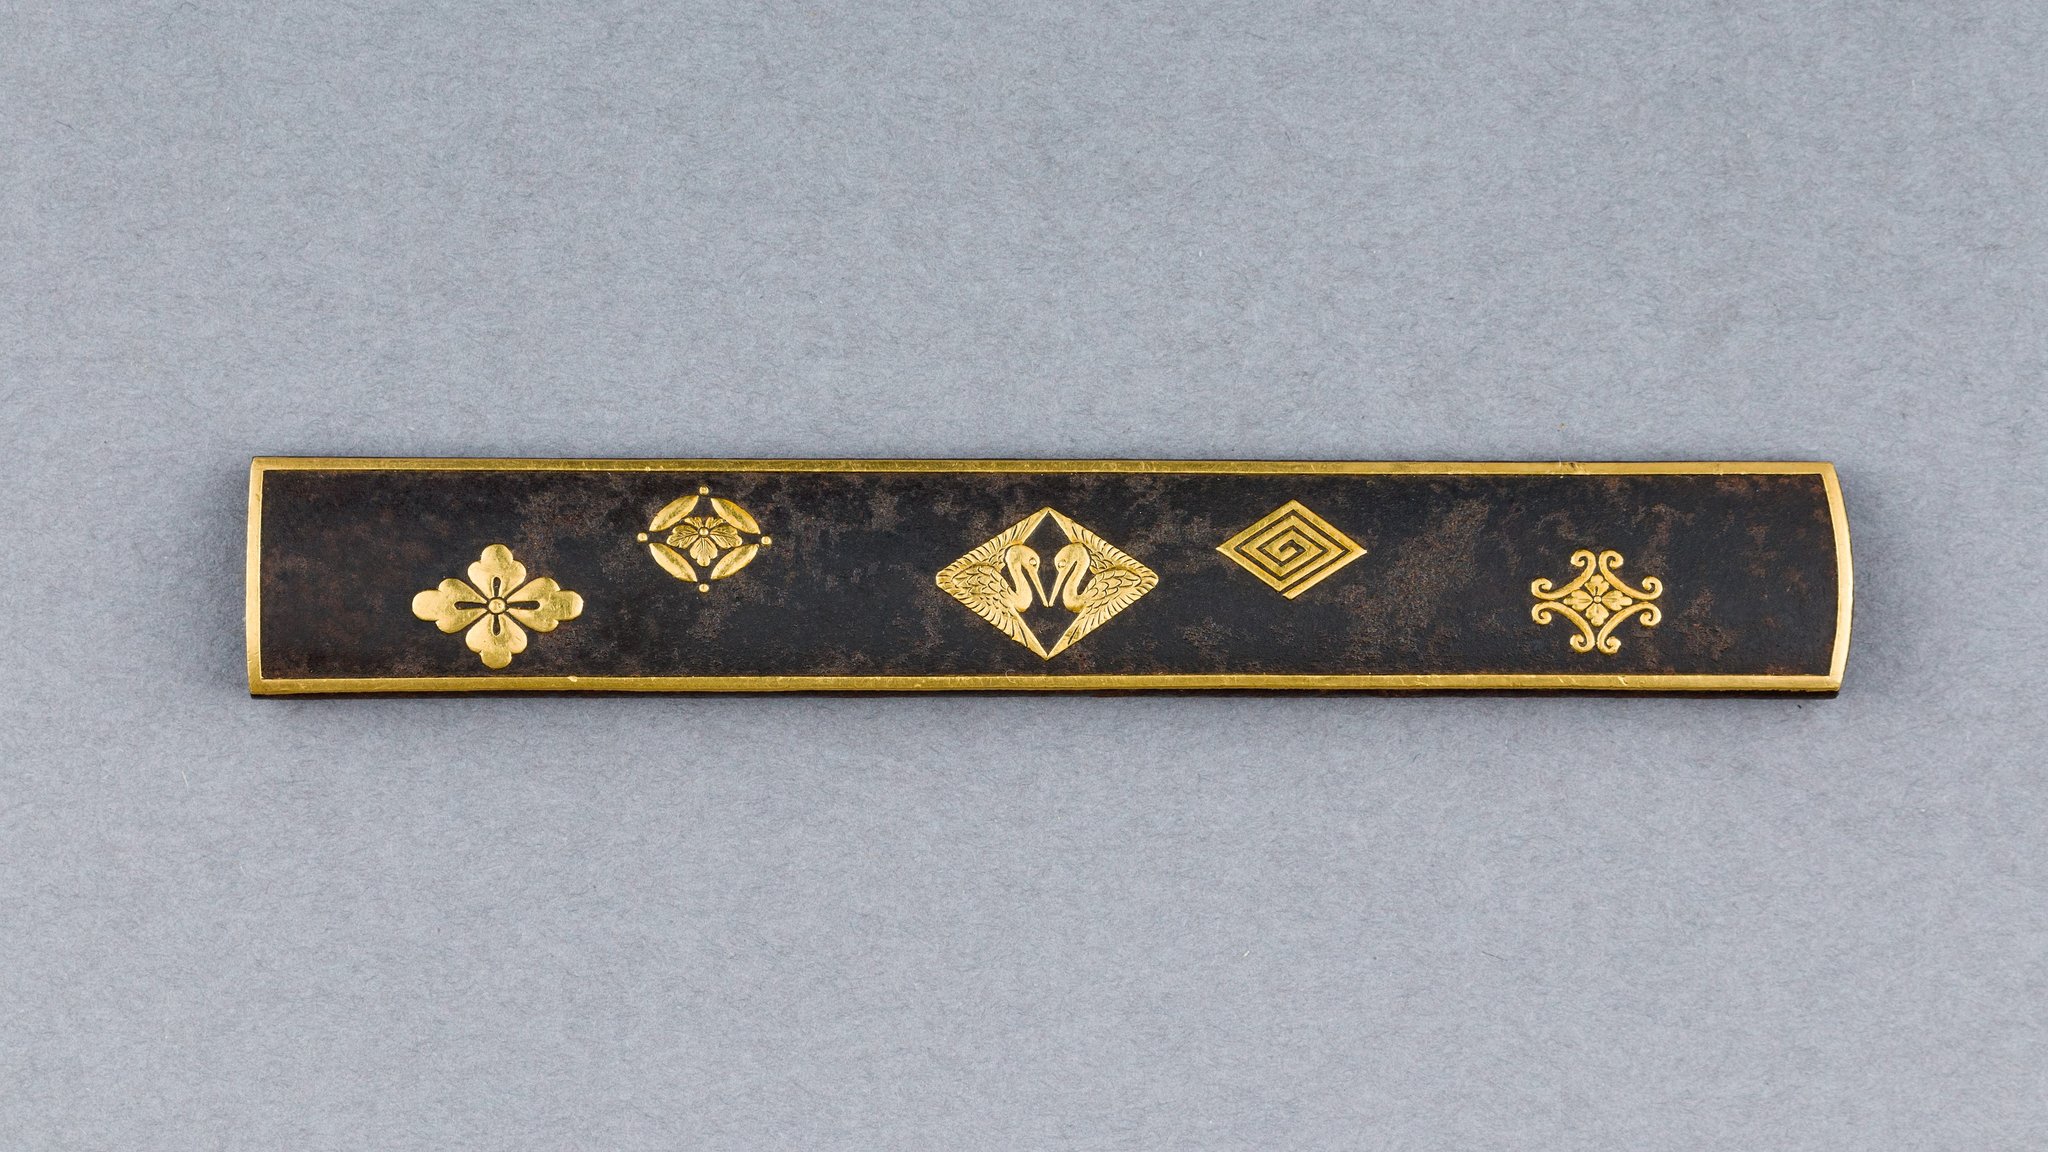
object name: knife handle kozuka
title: Knife Handle (Kozuka)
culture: japanese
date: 1615-1868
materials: silver alloy, gold, iron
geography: japan